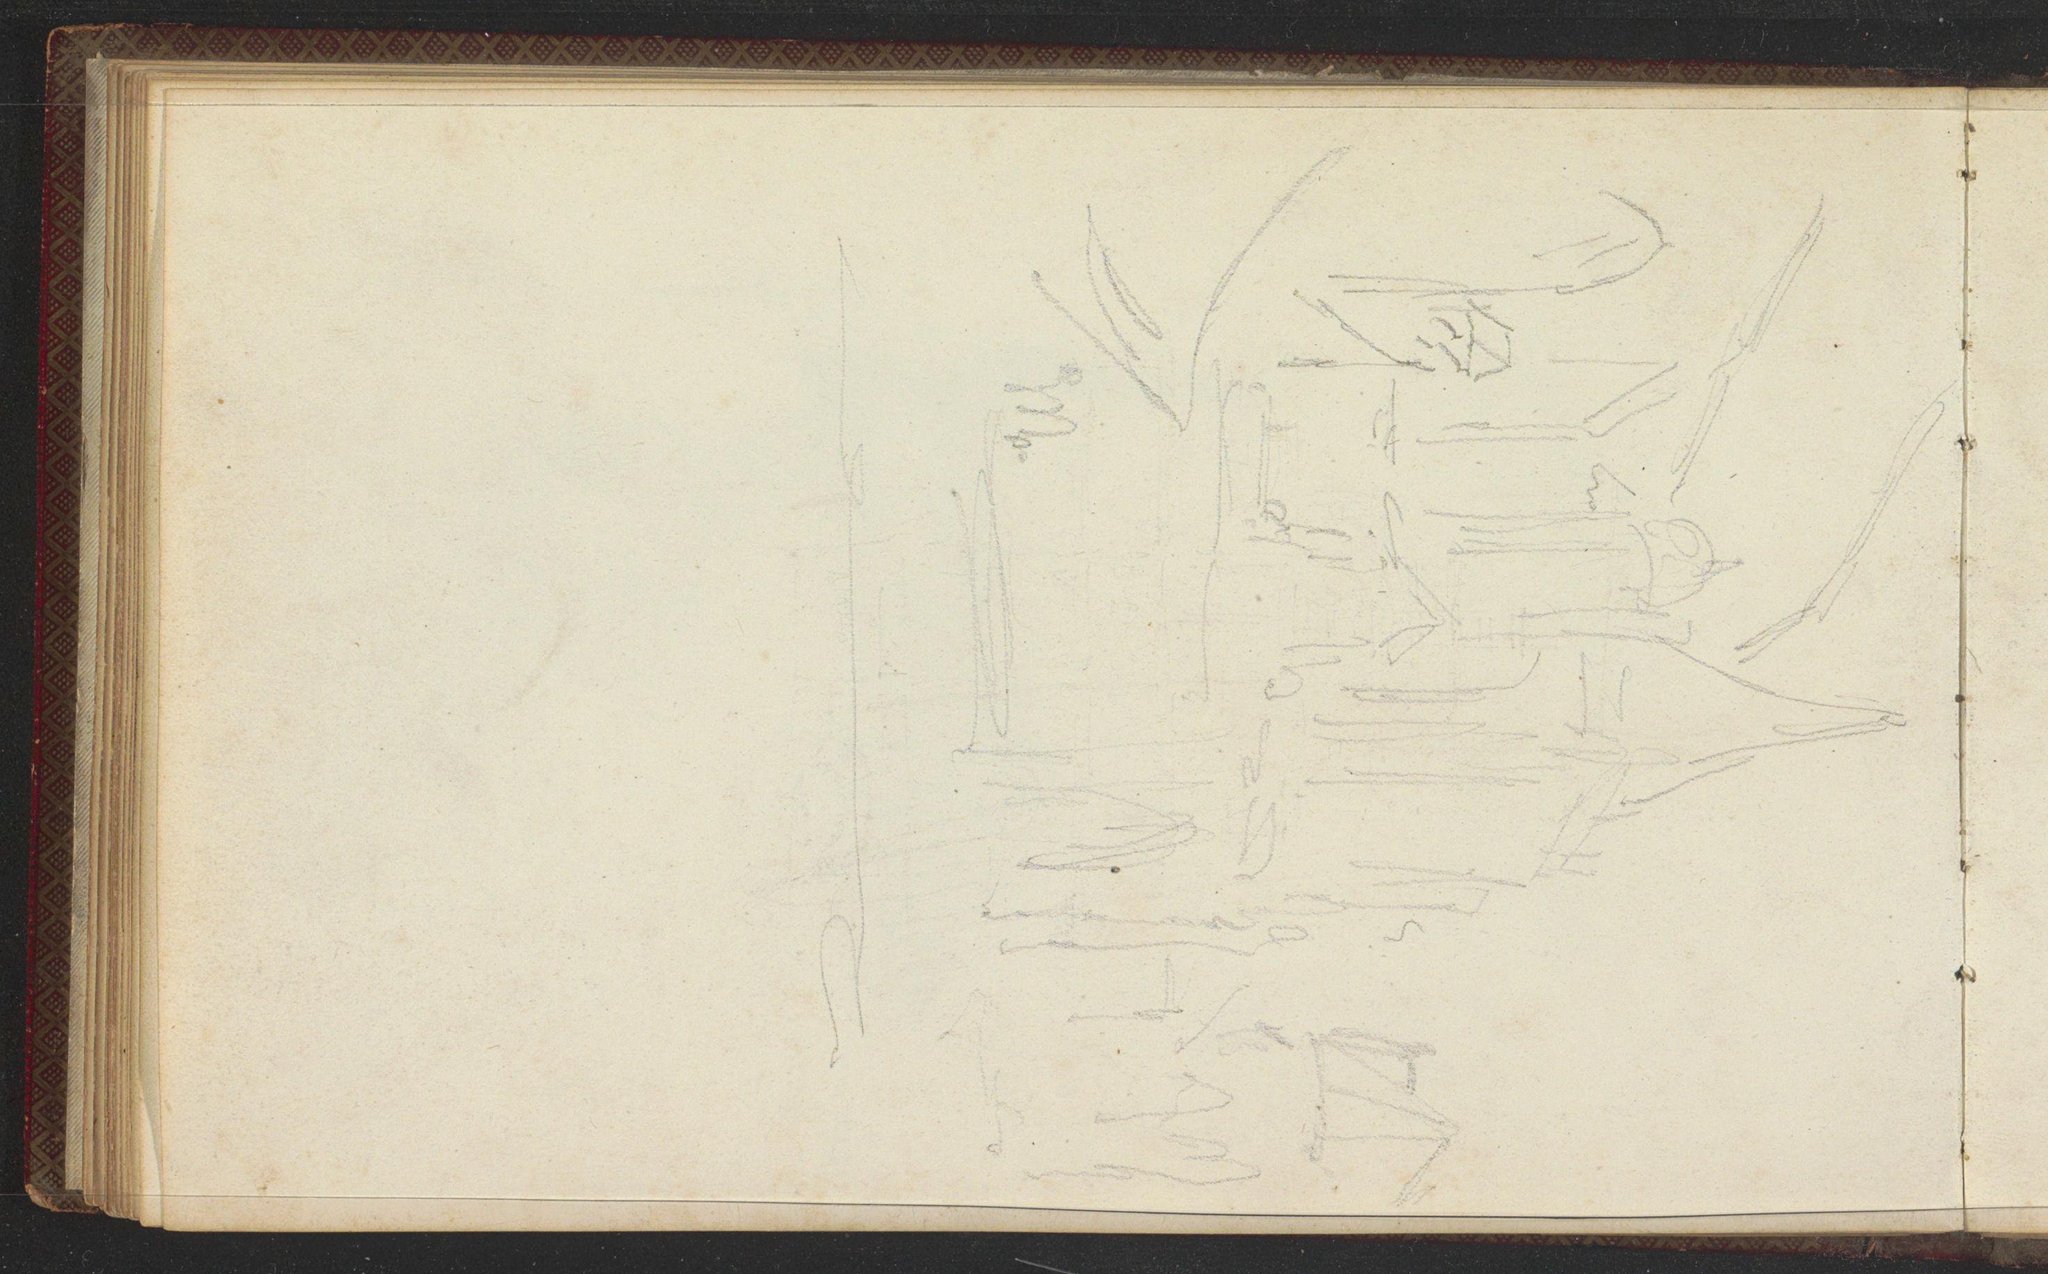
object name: sketchbook leaf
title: Gezicht op een kerk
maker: adrianus eversen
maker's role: draughtsman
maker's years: 1818-1897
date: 1828-1897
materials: paper, pencil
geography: netherlands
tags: church (exterior)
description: Gezicht op een kerk. Blad 32 recto uit een schetsboek met 52 bladen vervaardigd in de omgeving van Kampen, Hattem, Hoorn en Zwolle.